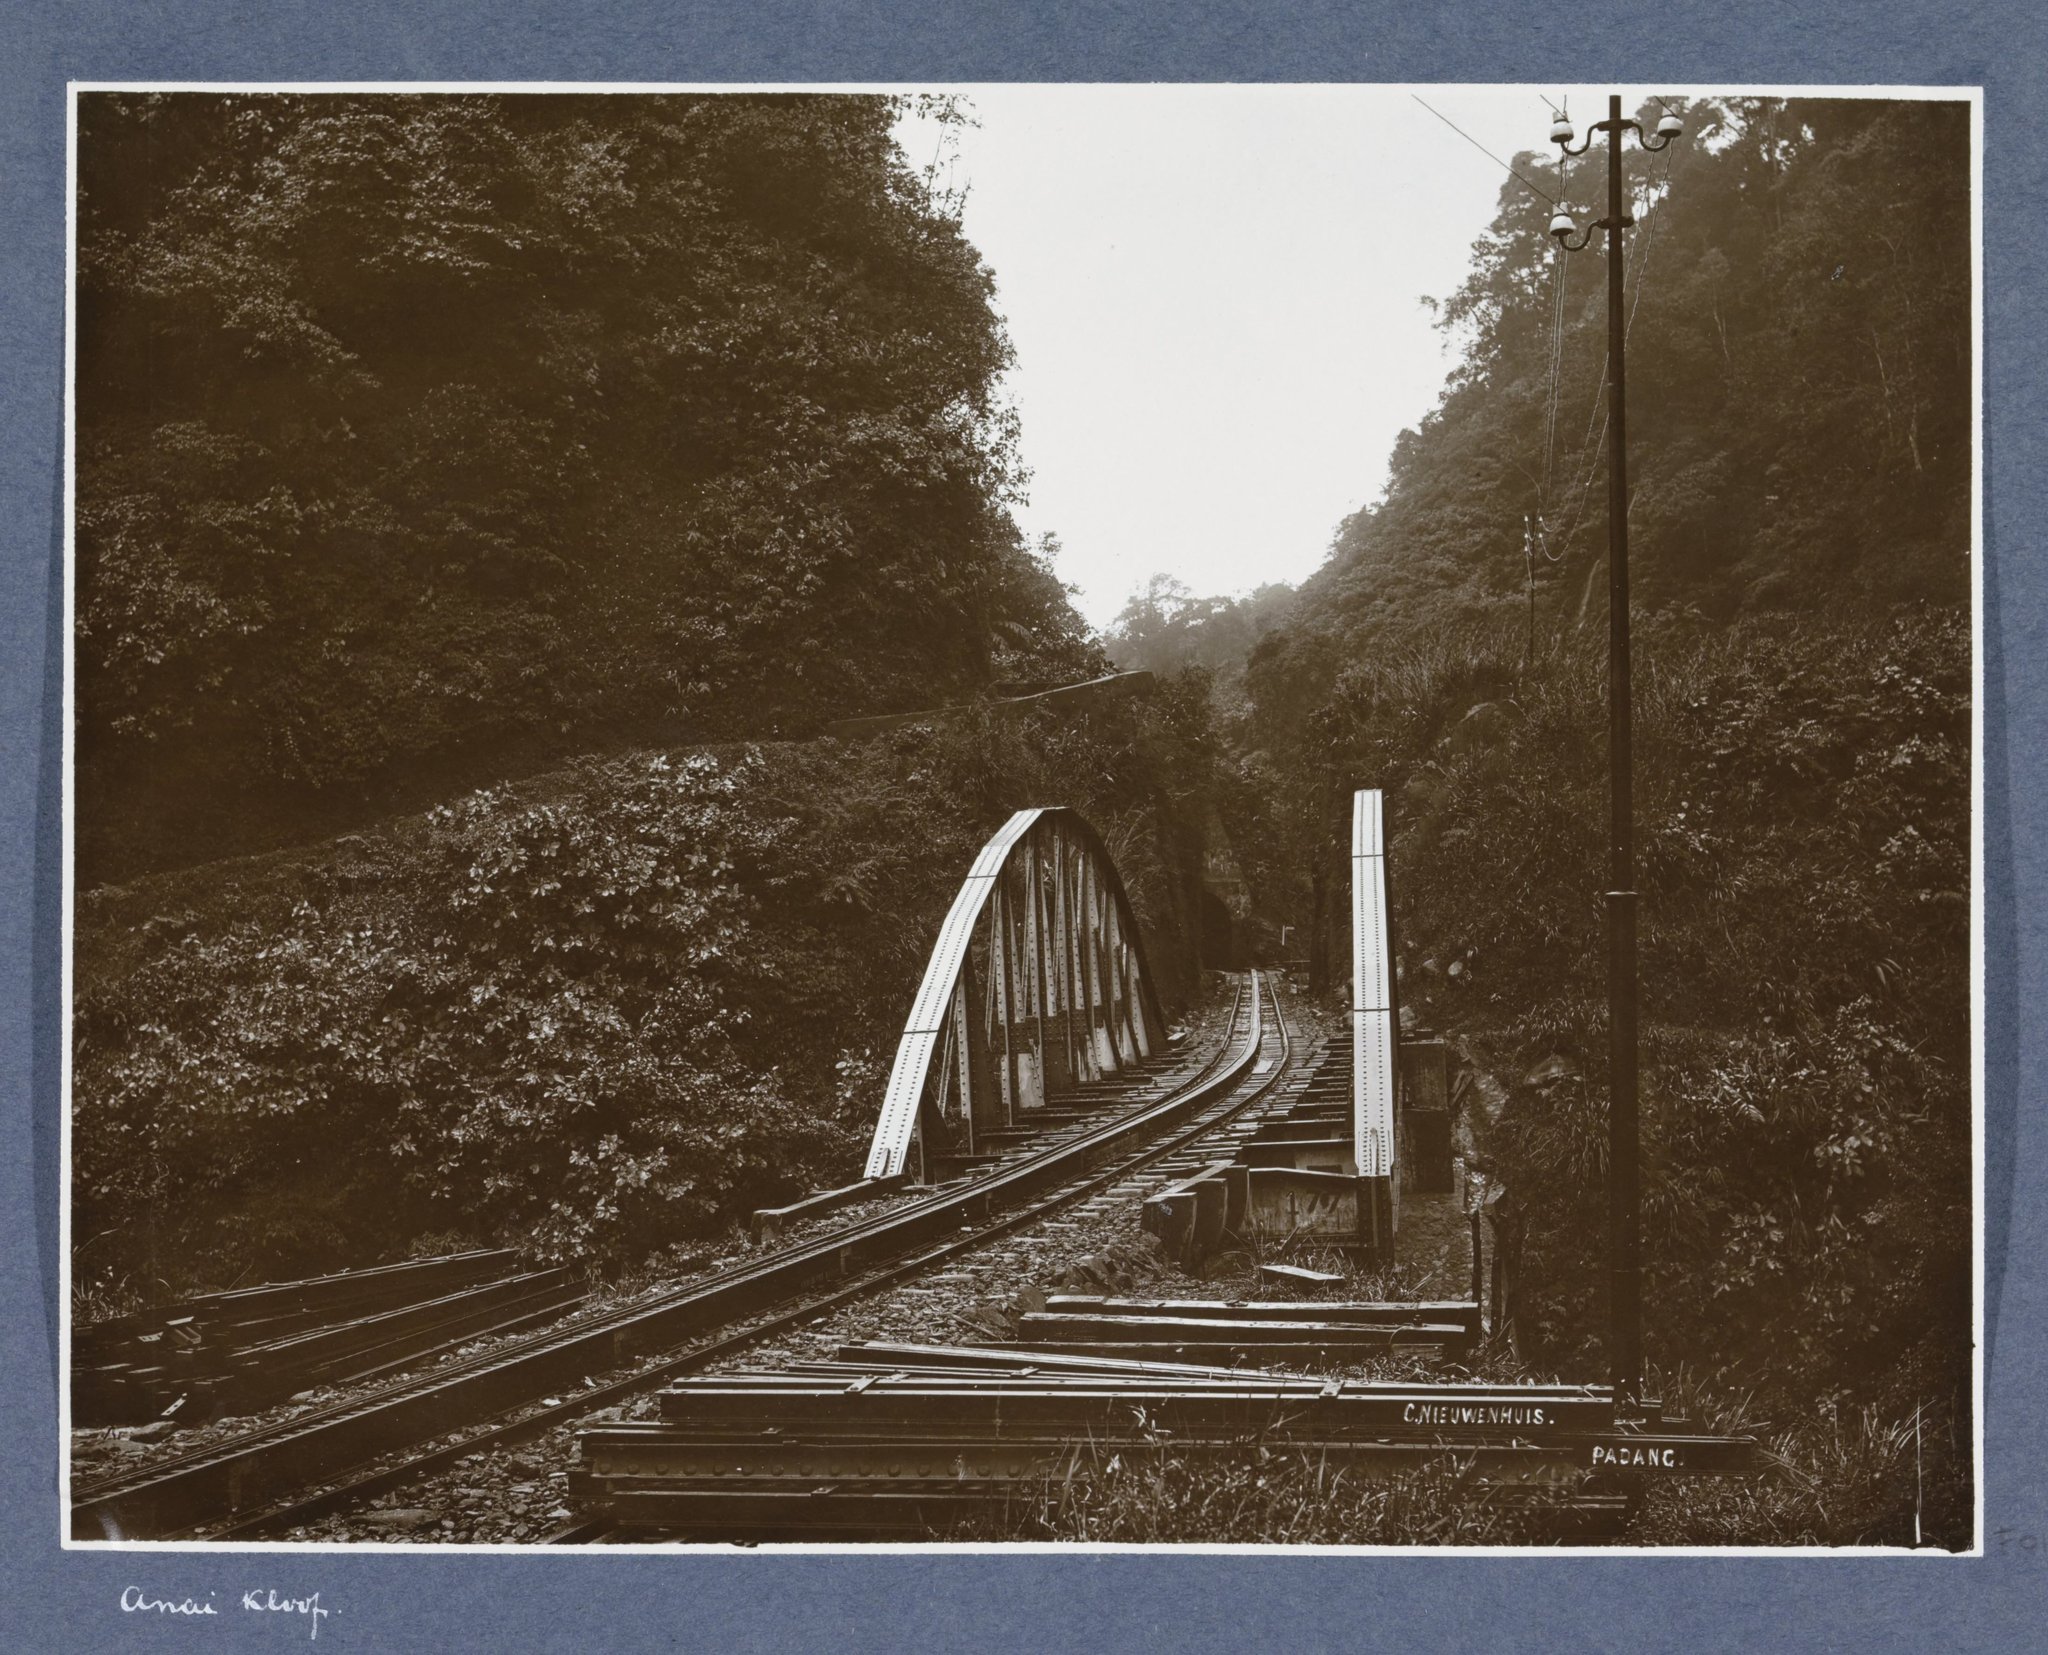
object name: photograph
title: Spoorbrug met tandradspoorbaan in de Anaikloof op Sumatra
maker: christiaan benjamin nieuwenhuis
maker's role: publisher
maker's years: 1863-1922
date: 1900-1920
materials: paper, photographic support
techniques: gelatin silver print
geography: sumatra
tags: funicular railway, ravine, chasm, abyss, canyon, railway, train, sumatra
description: Onderdeel van reisalbum met foto's van bedrijvigheid en bezienswaardigheden op Sumatra en Java en van de reis naar en van Nederlands-Indië.